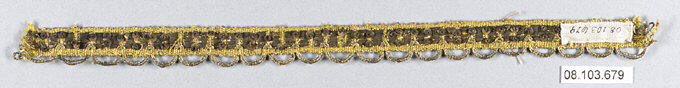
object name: passementerie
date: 1801-1900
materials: metal thread